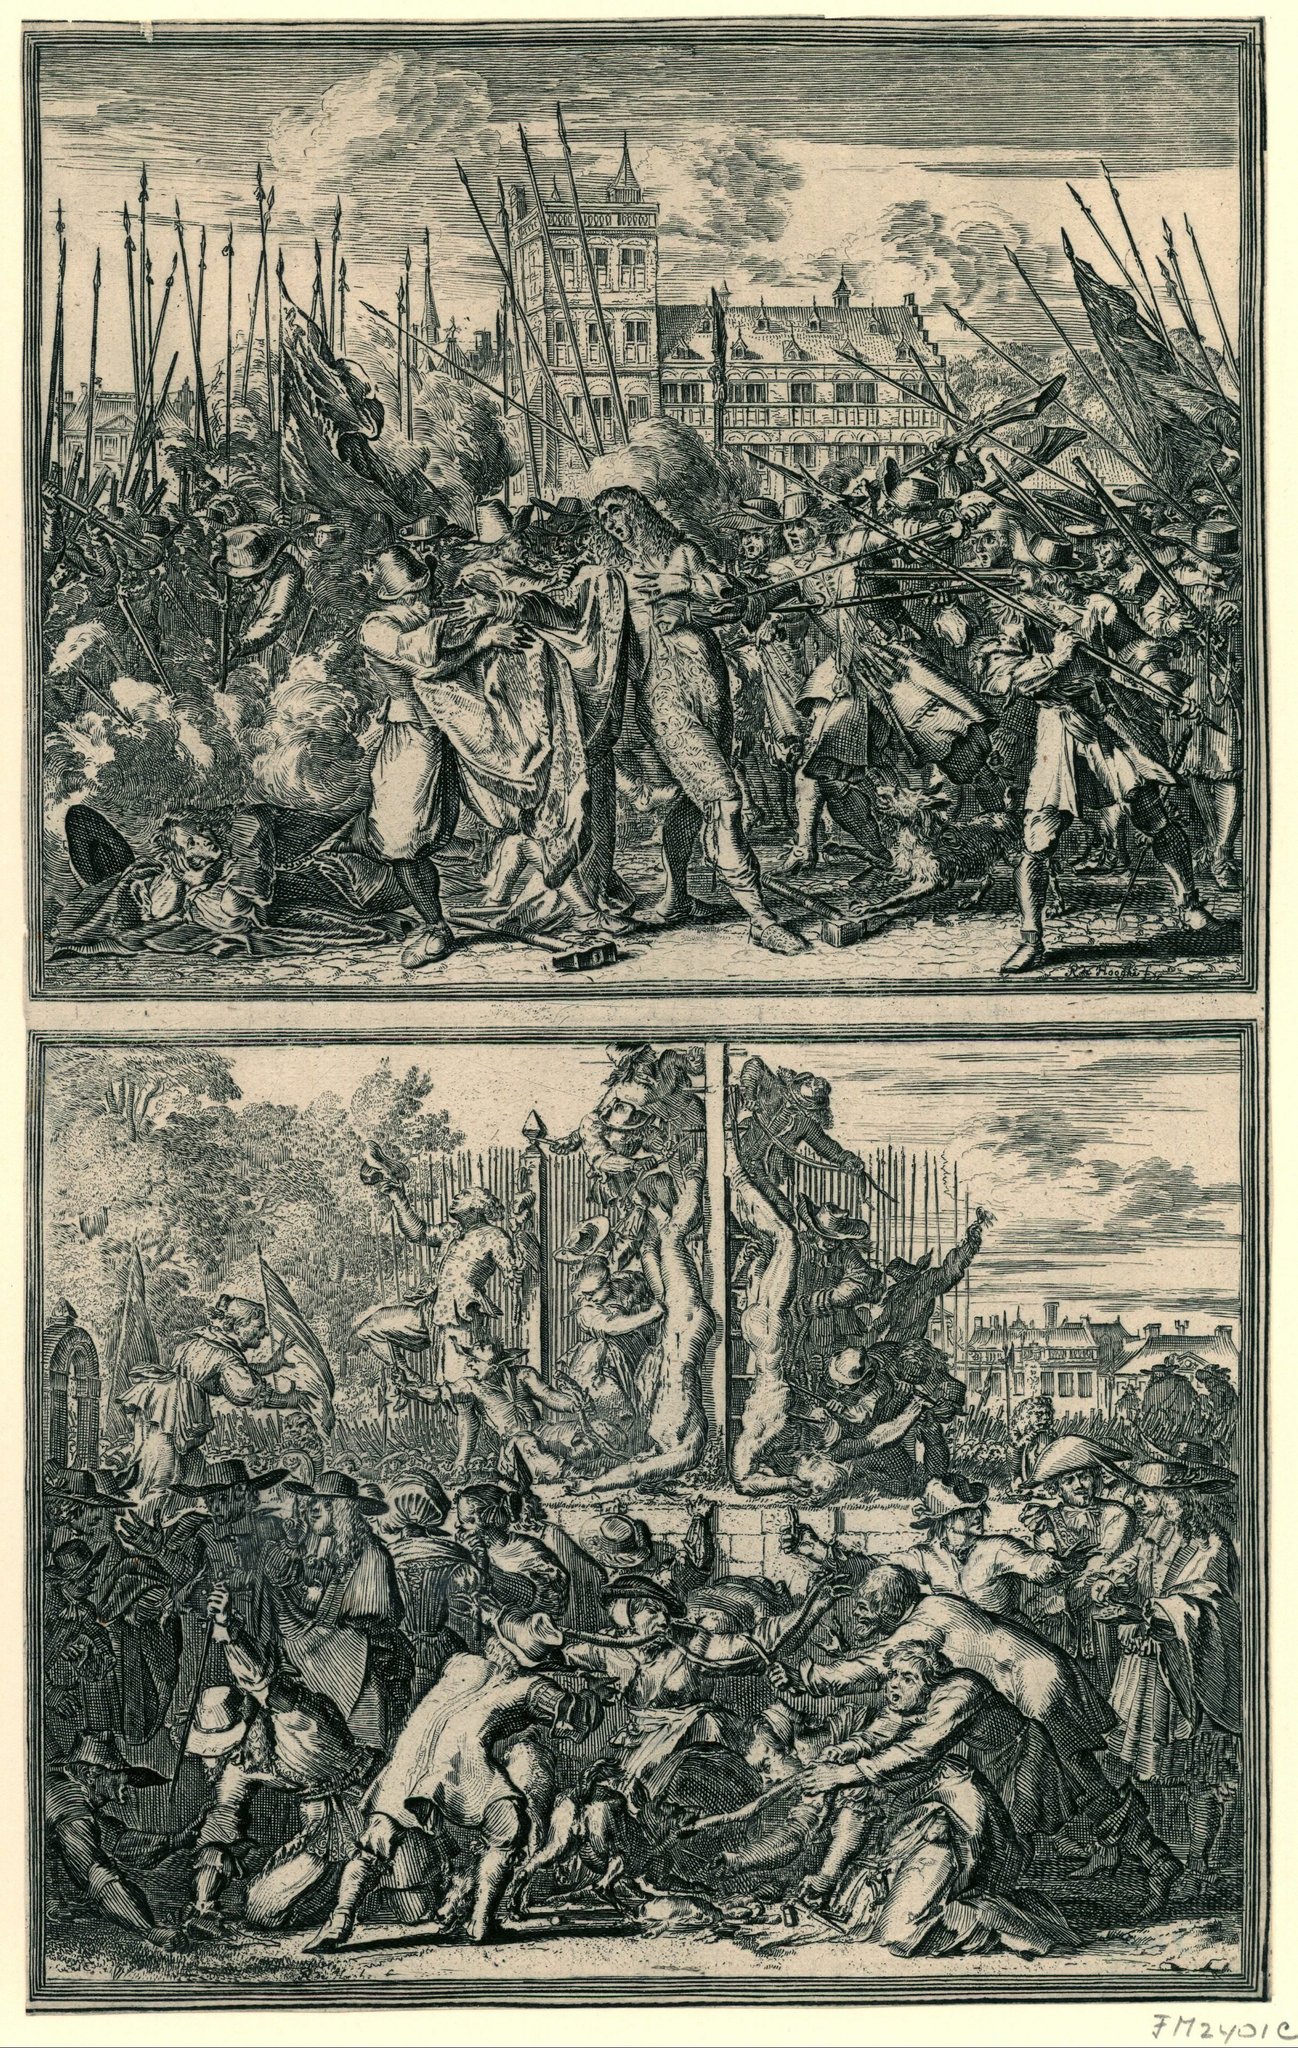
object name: print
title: Twee episodes uit de moord op de gebroeders De Witt, 1672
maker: romeyn de hooghe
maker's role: draughtsman, goldsmith, painter, print maker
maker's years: 1645-1708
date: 1672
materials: paper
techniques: engraving, etching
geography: northern netherlands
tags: dordrecht, the hague, cornelis de witt, politician, johan de witt, lynching, attempt, political murder, violent death, being killed; being mishandled and maltreated; seeking death (+ death by lynching)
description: Twee episodes uit de moord op de gebroeders De Witt, 20 augutsus 1672. Boven de moord op Johan en Cornelis de Witt en onder het verminken van de lichamen op het schavot.